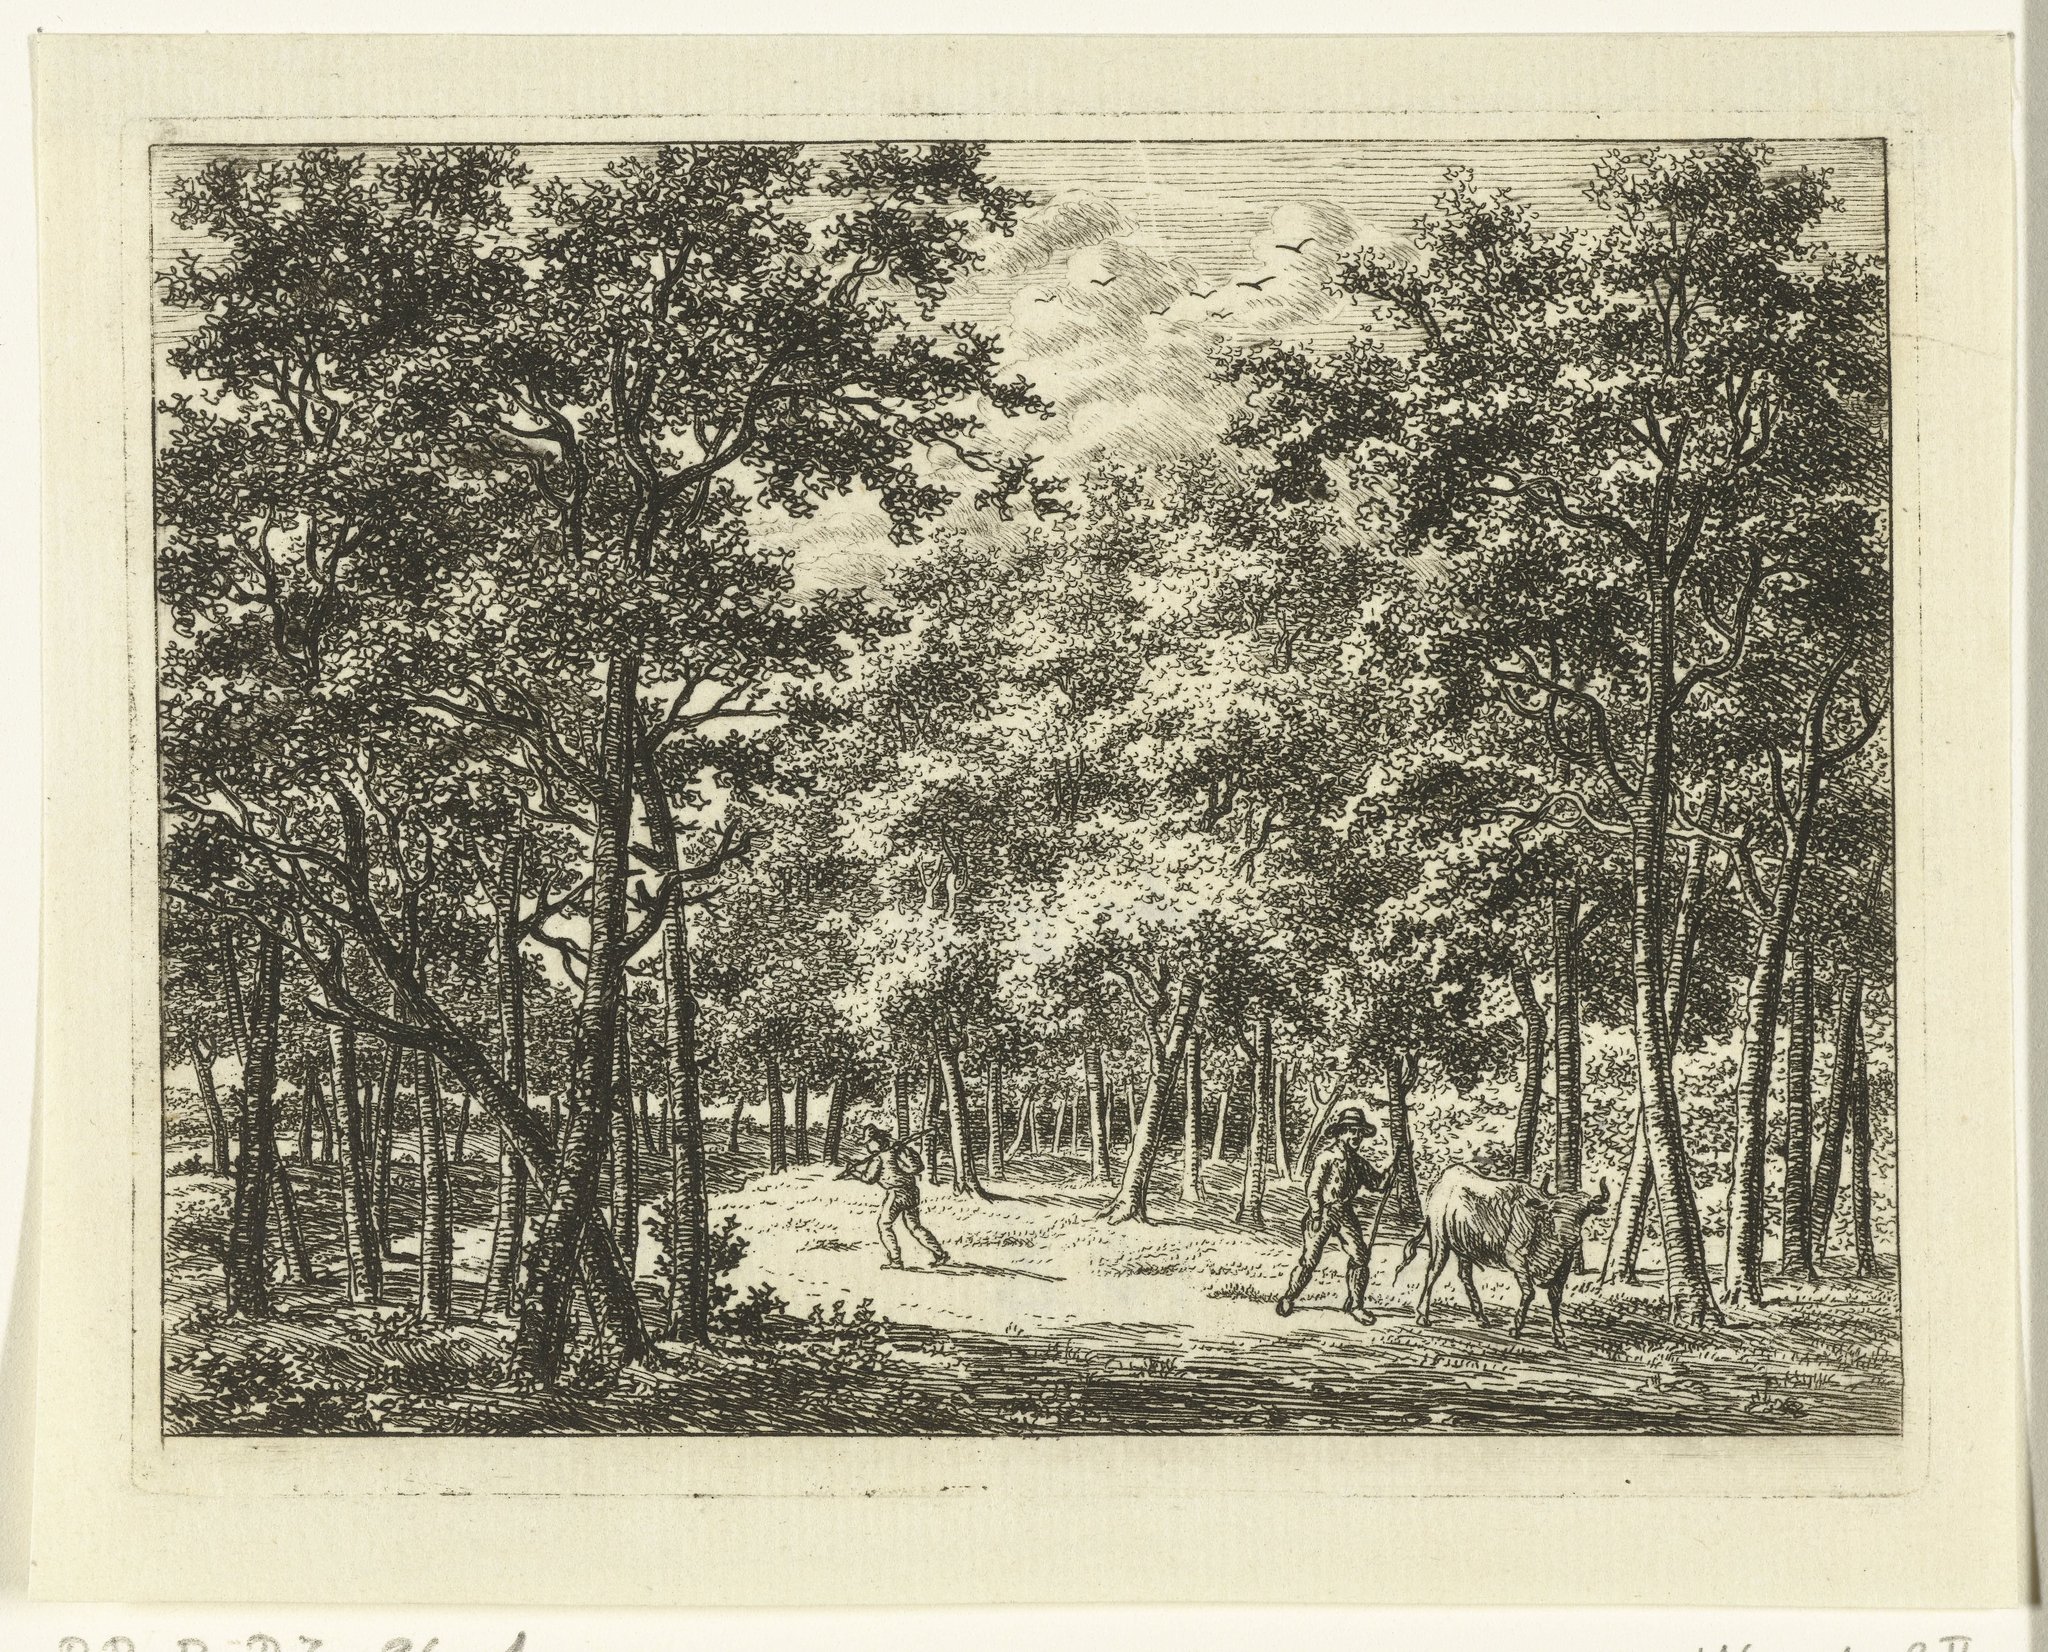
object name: print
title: Herder met koe in het bos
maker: ernst willem jan bagelaar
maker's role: draughtsman, print maker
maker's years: 1775-1837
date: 1798-1837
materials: paper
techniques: drypoint, etching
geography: netherlands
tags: forest, wood (+ landscape with figures, staffage)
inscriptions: collector's mark: Lugt 2228